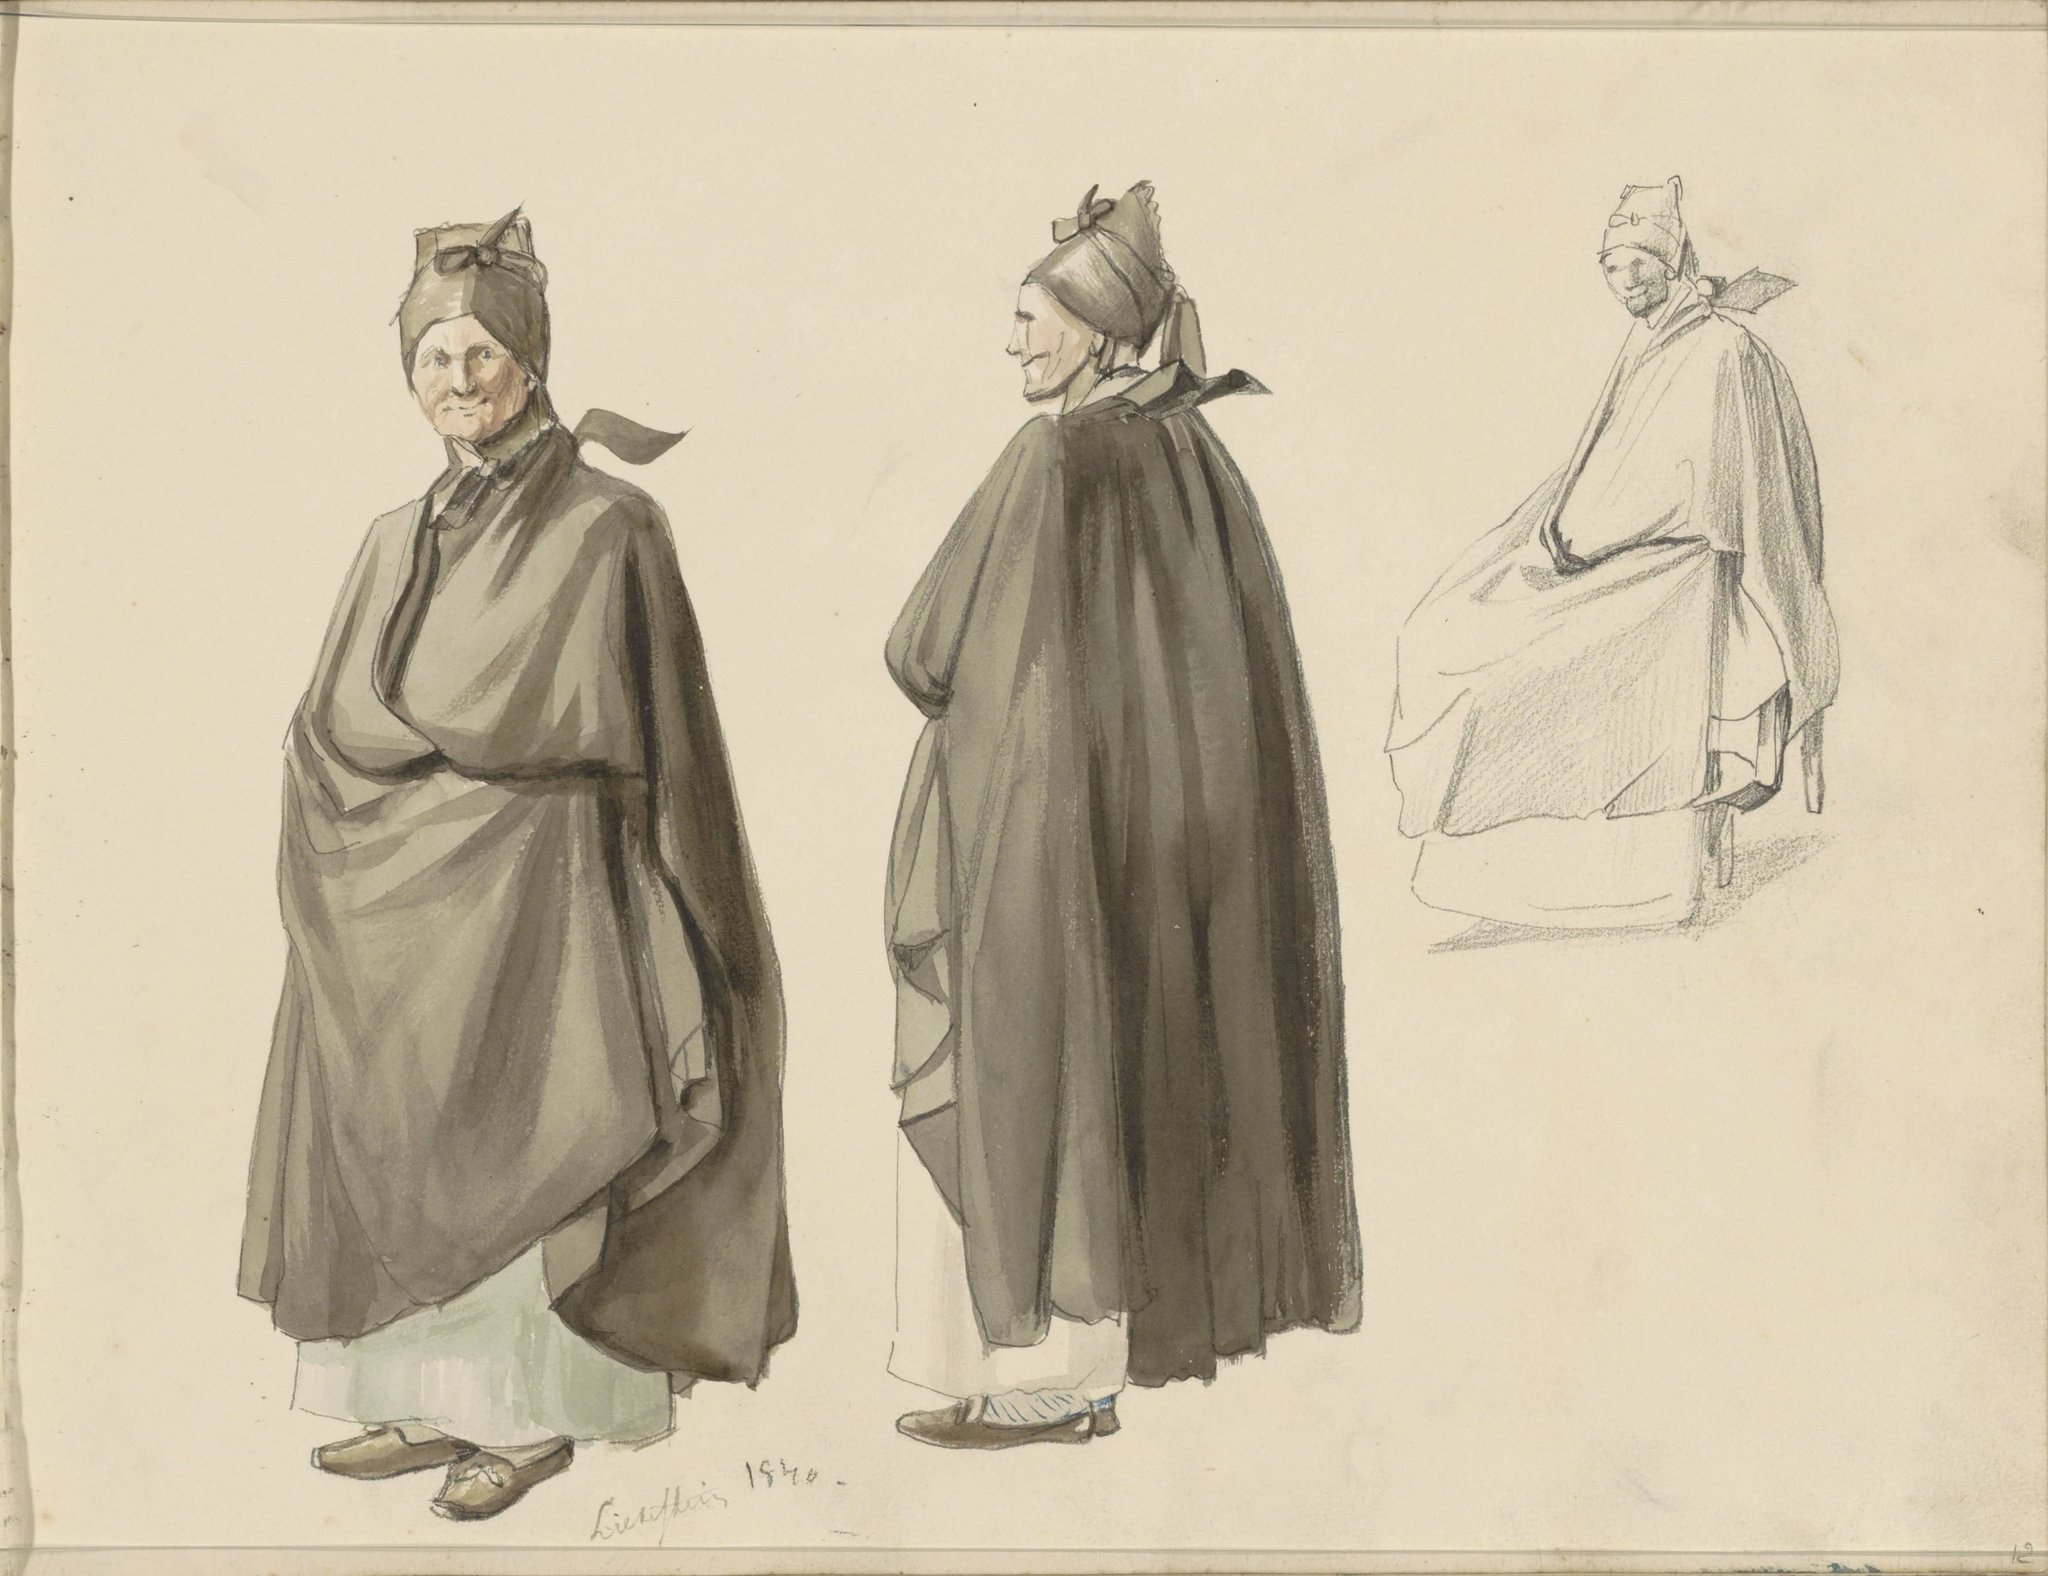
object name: sketchbook leaf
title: Vrouw in een lange mantel en kap, uit verschillende aanzichten gezien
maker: johannes tavenraat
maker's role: draughtsman, painter, print maker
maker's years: 1809-1881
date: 1840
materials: paper, pencil, watercolor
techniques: brush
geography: liebenstein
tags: adult woman, coat (+ women's clothes), head-gear: cap (+ women's clothes)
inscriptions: date and inscription: ‘Liebestein 1840.’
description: Blad 12 recto uit een schetsboek met 43 bladen.